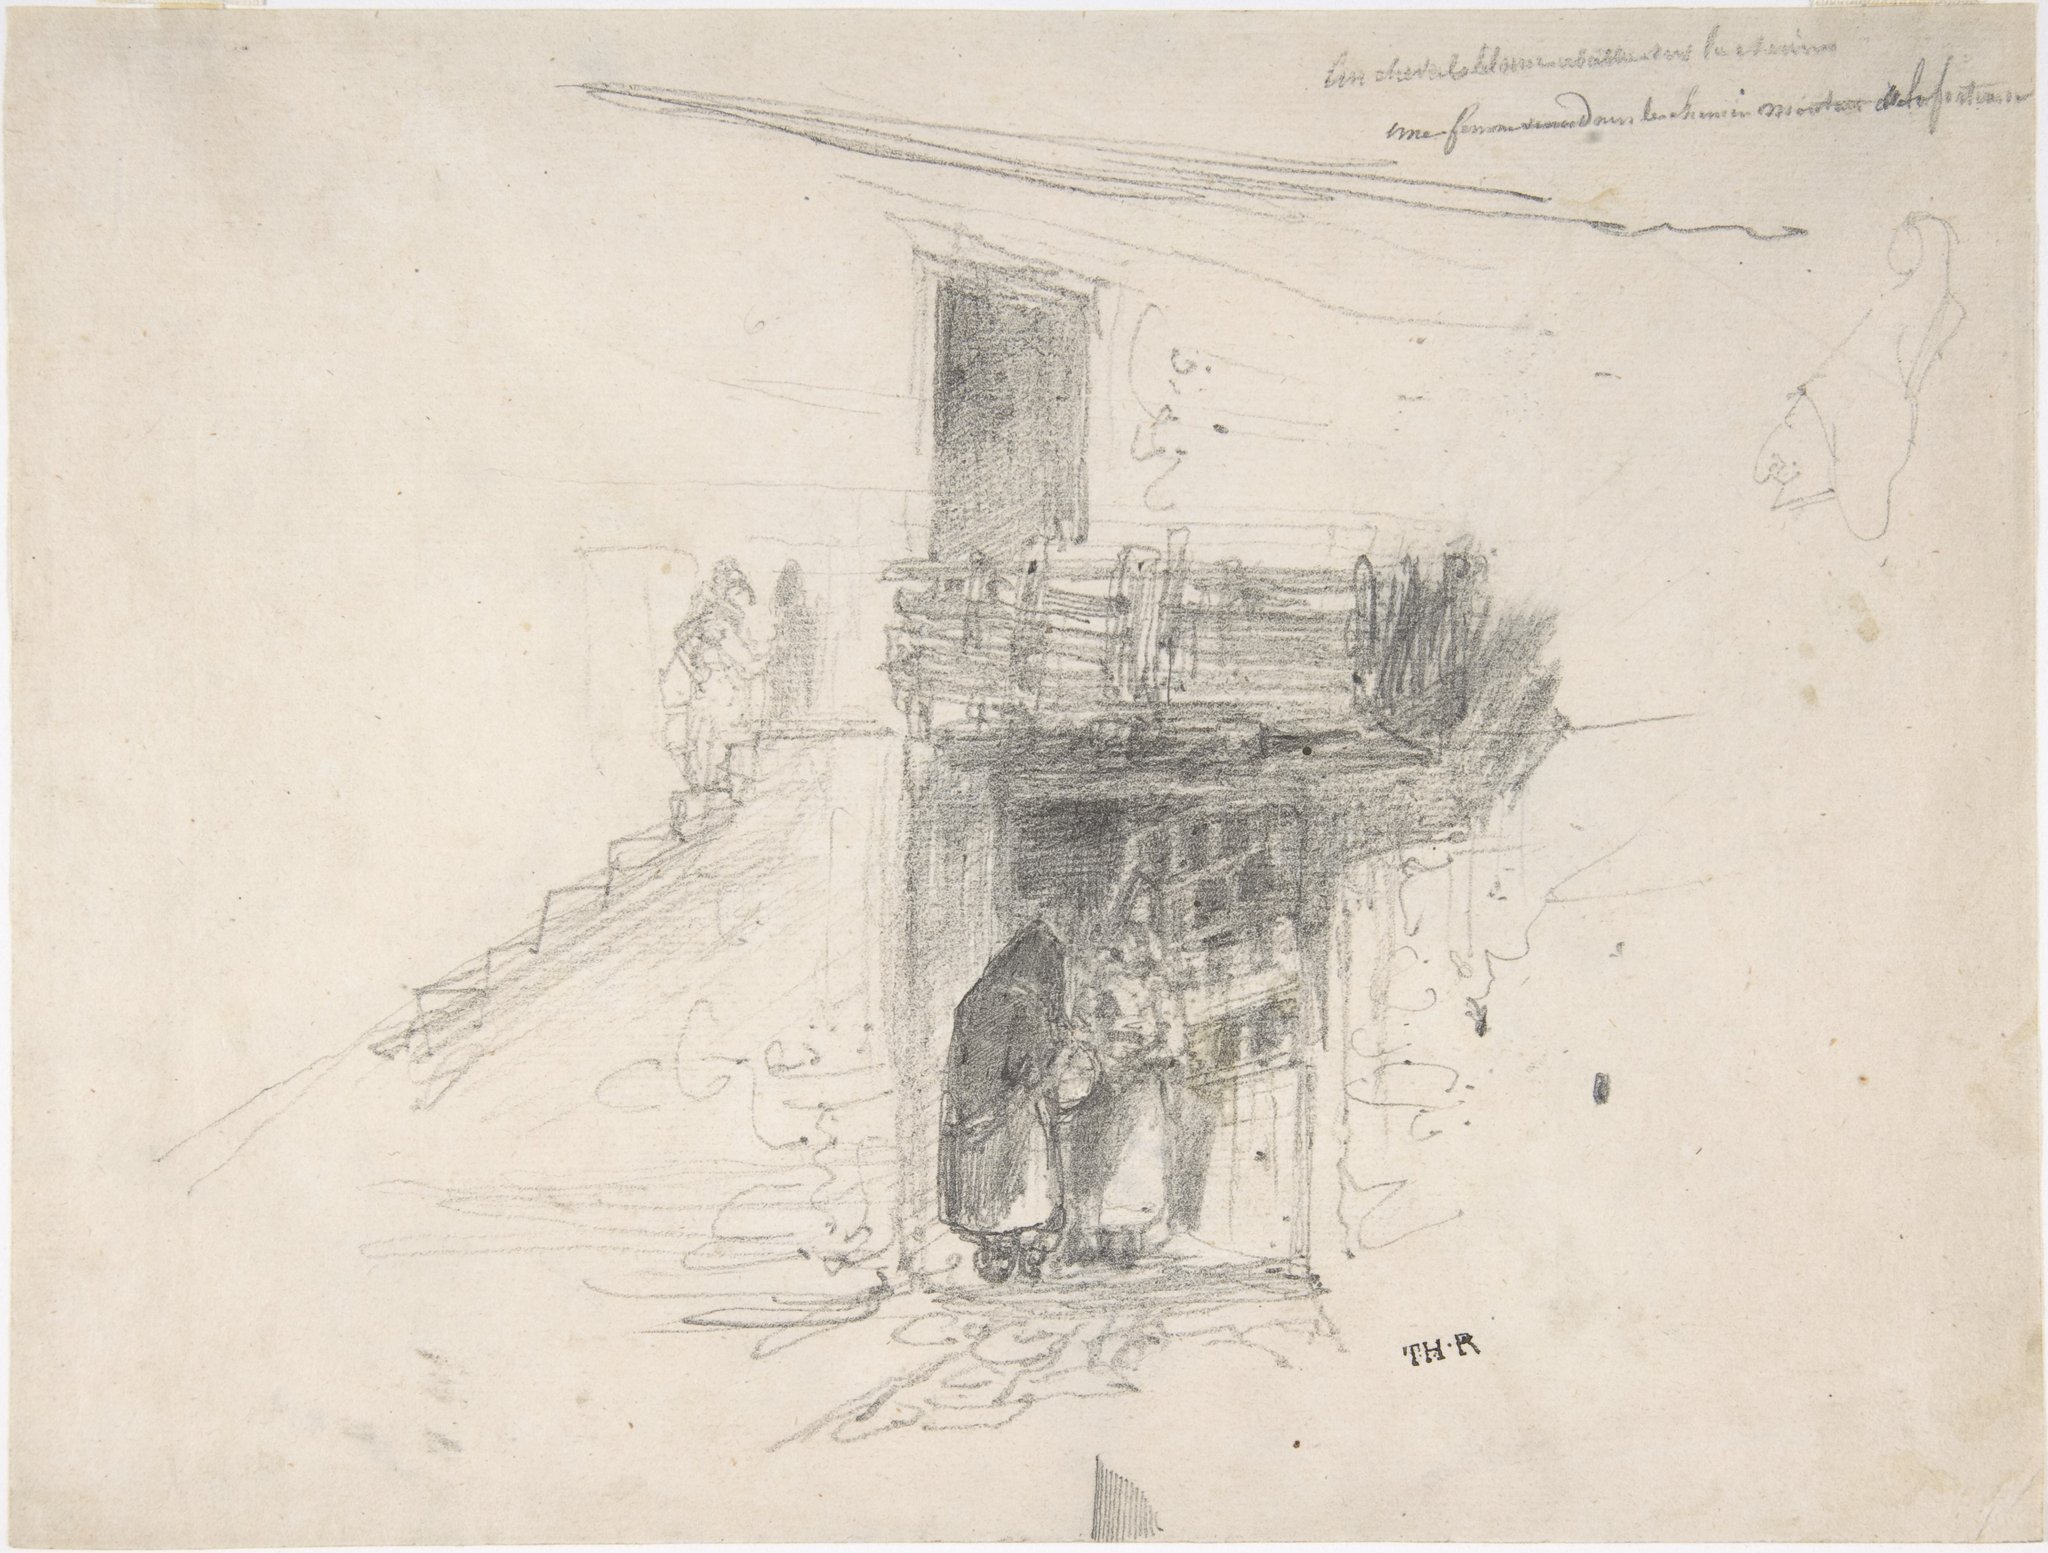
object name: drawing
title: Two Women Talking in a Doorway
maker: théodore rousseau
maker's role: artist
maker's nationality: french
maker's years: 1812-1867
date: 1830-1831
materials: graphite, paper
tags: doorways,women